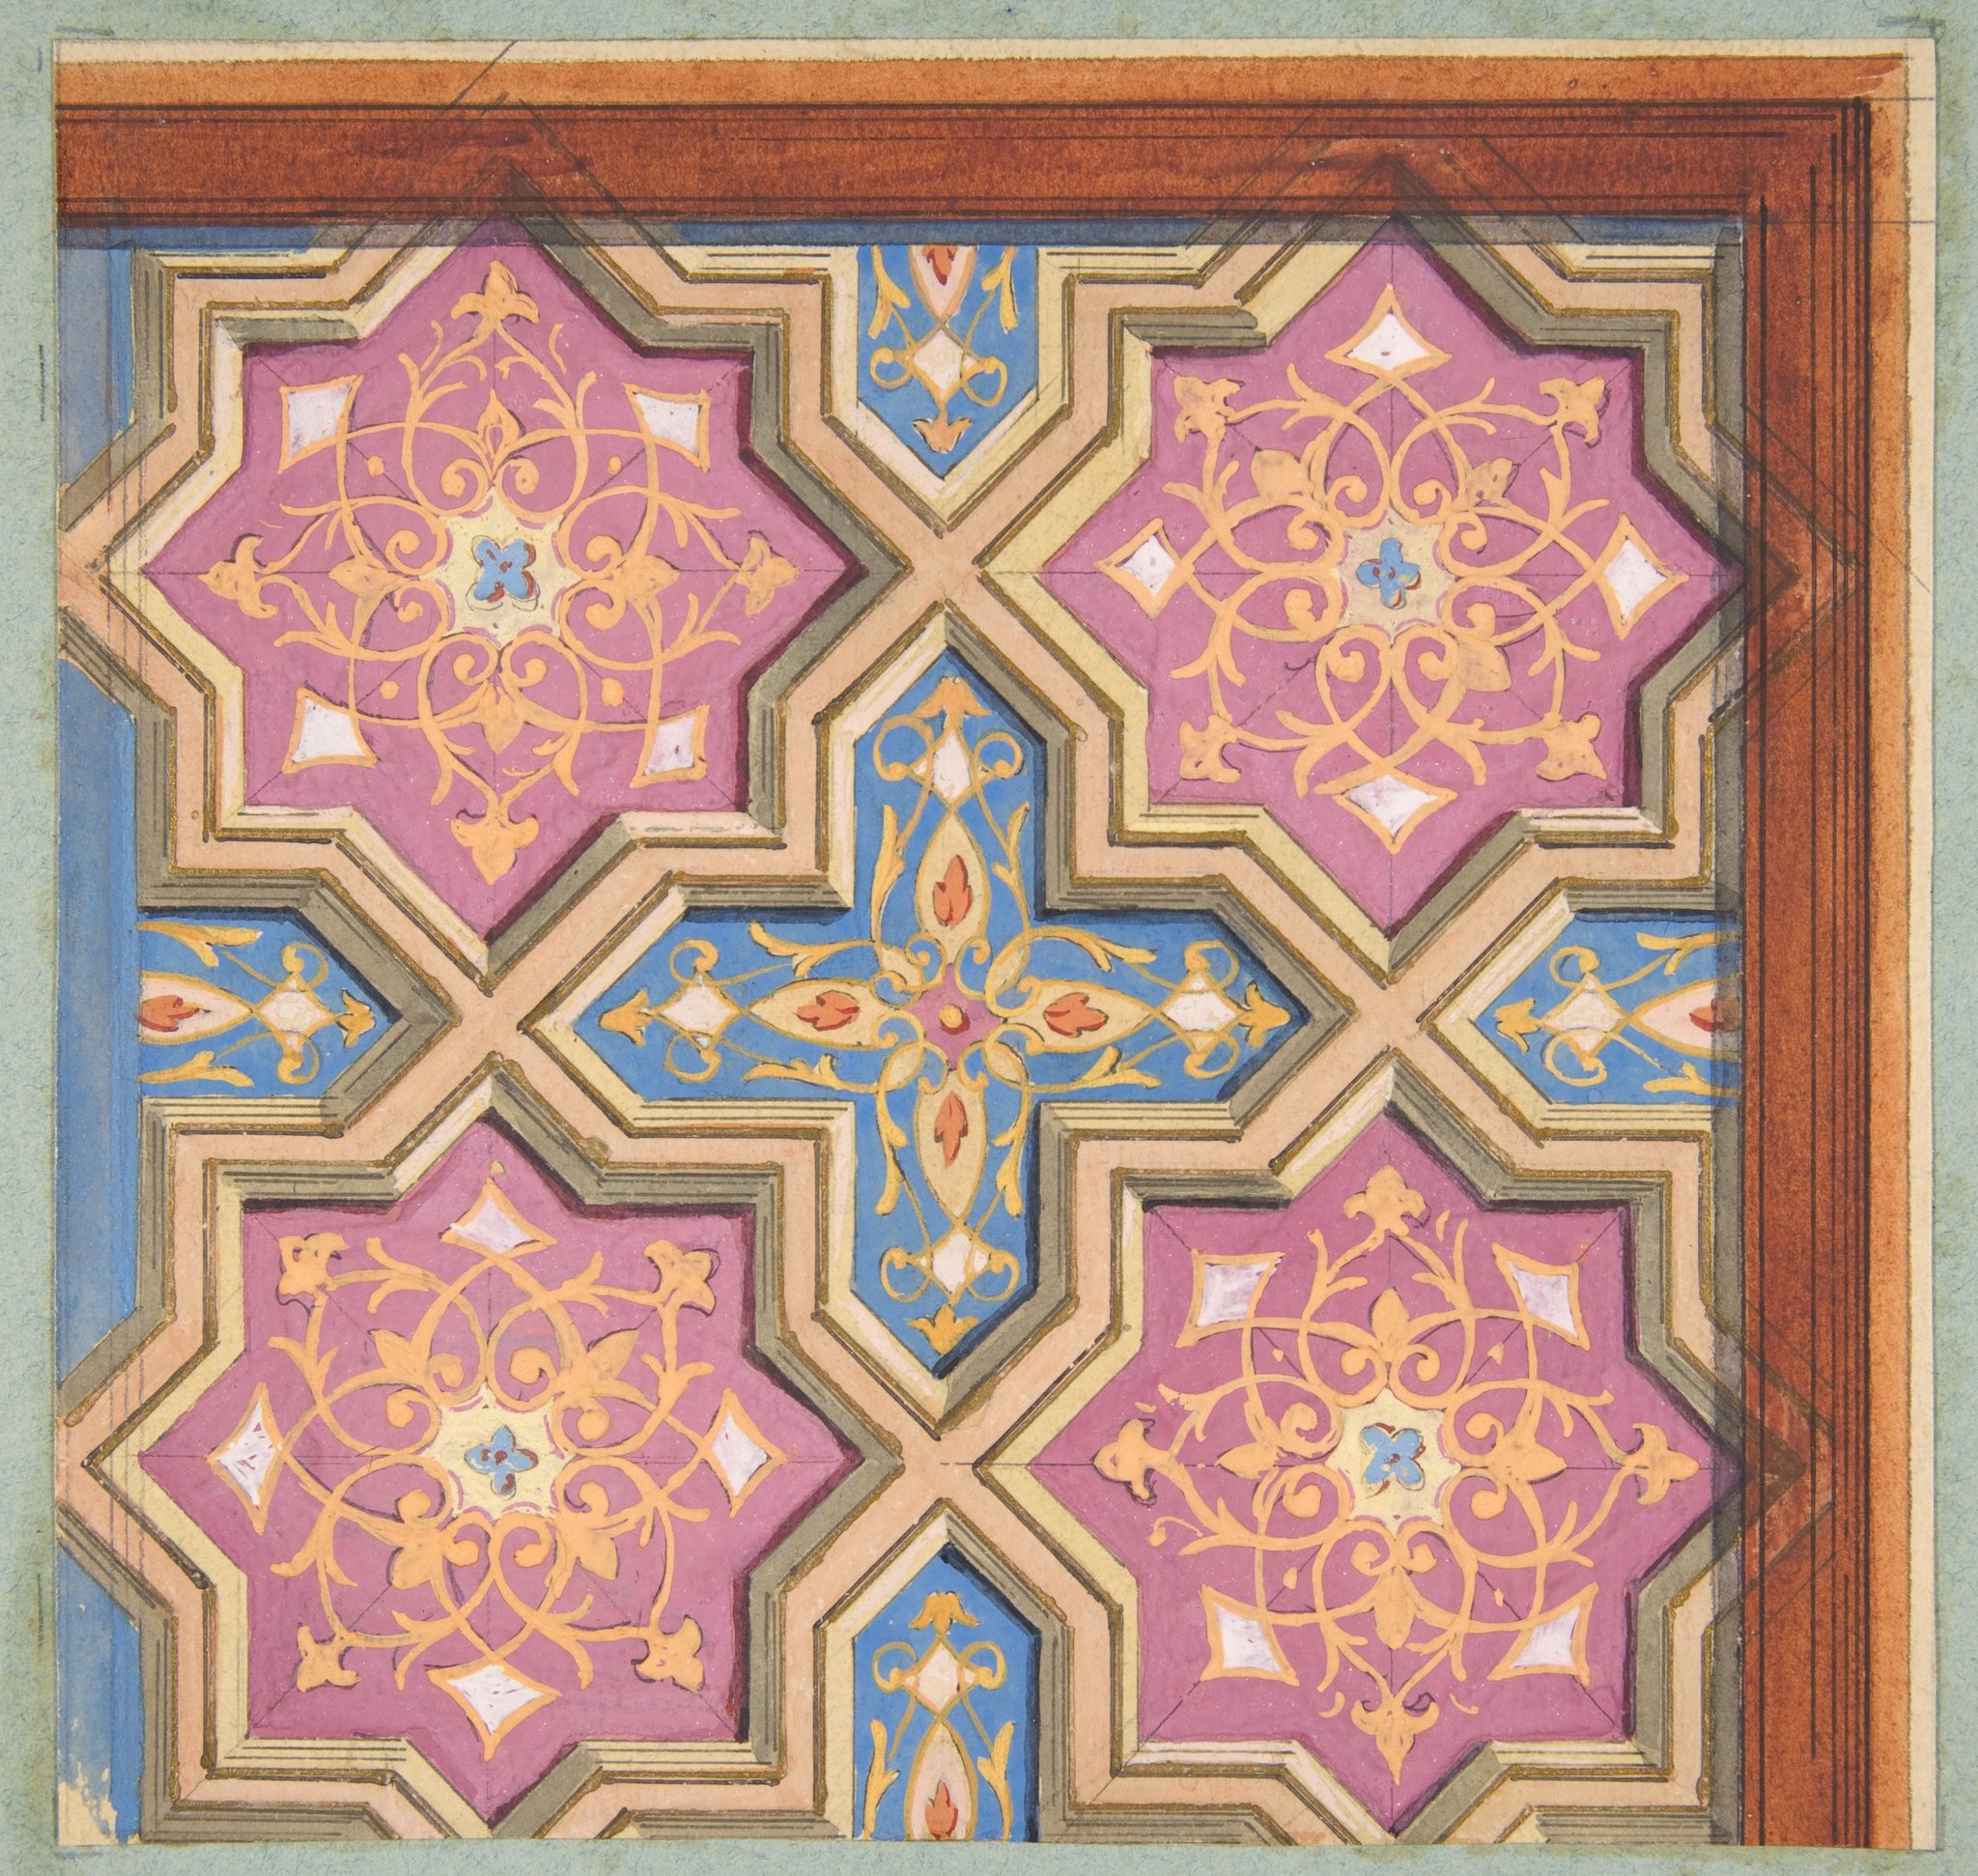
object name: drawing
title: Partial design for the decoration of a ceiling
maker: jules-edmond-charles lachaise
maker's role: artist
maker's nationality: french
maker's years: 1897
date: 1840-1897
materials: gouache, graphite, ink, watercolor, paper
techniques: inlay, pen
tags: ceilings